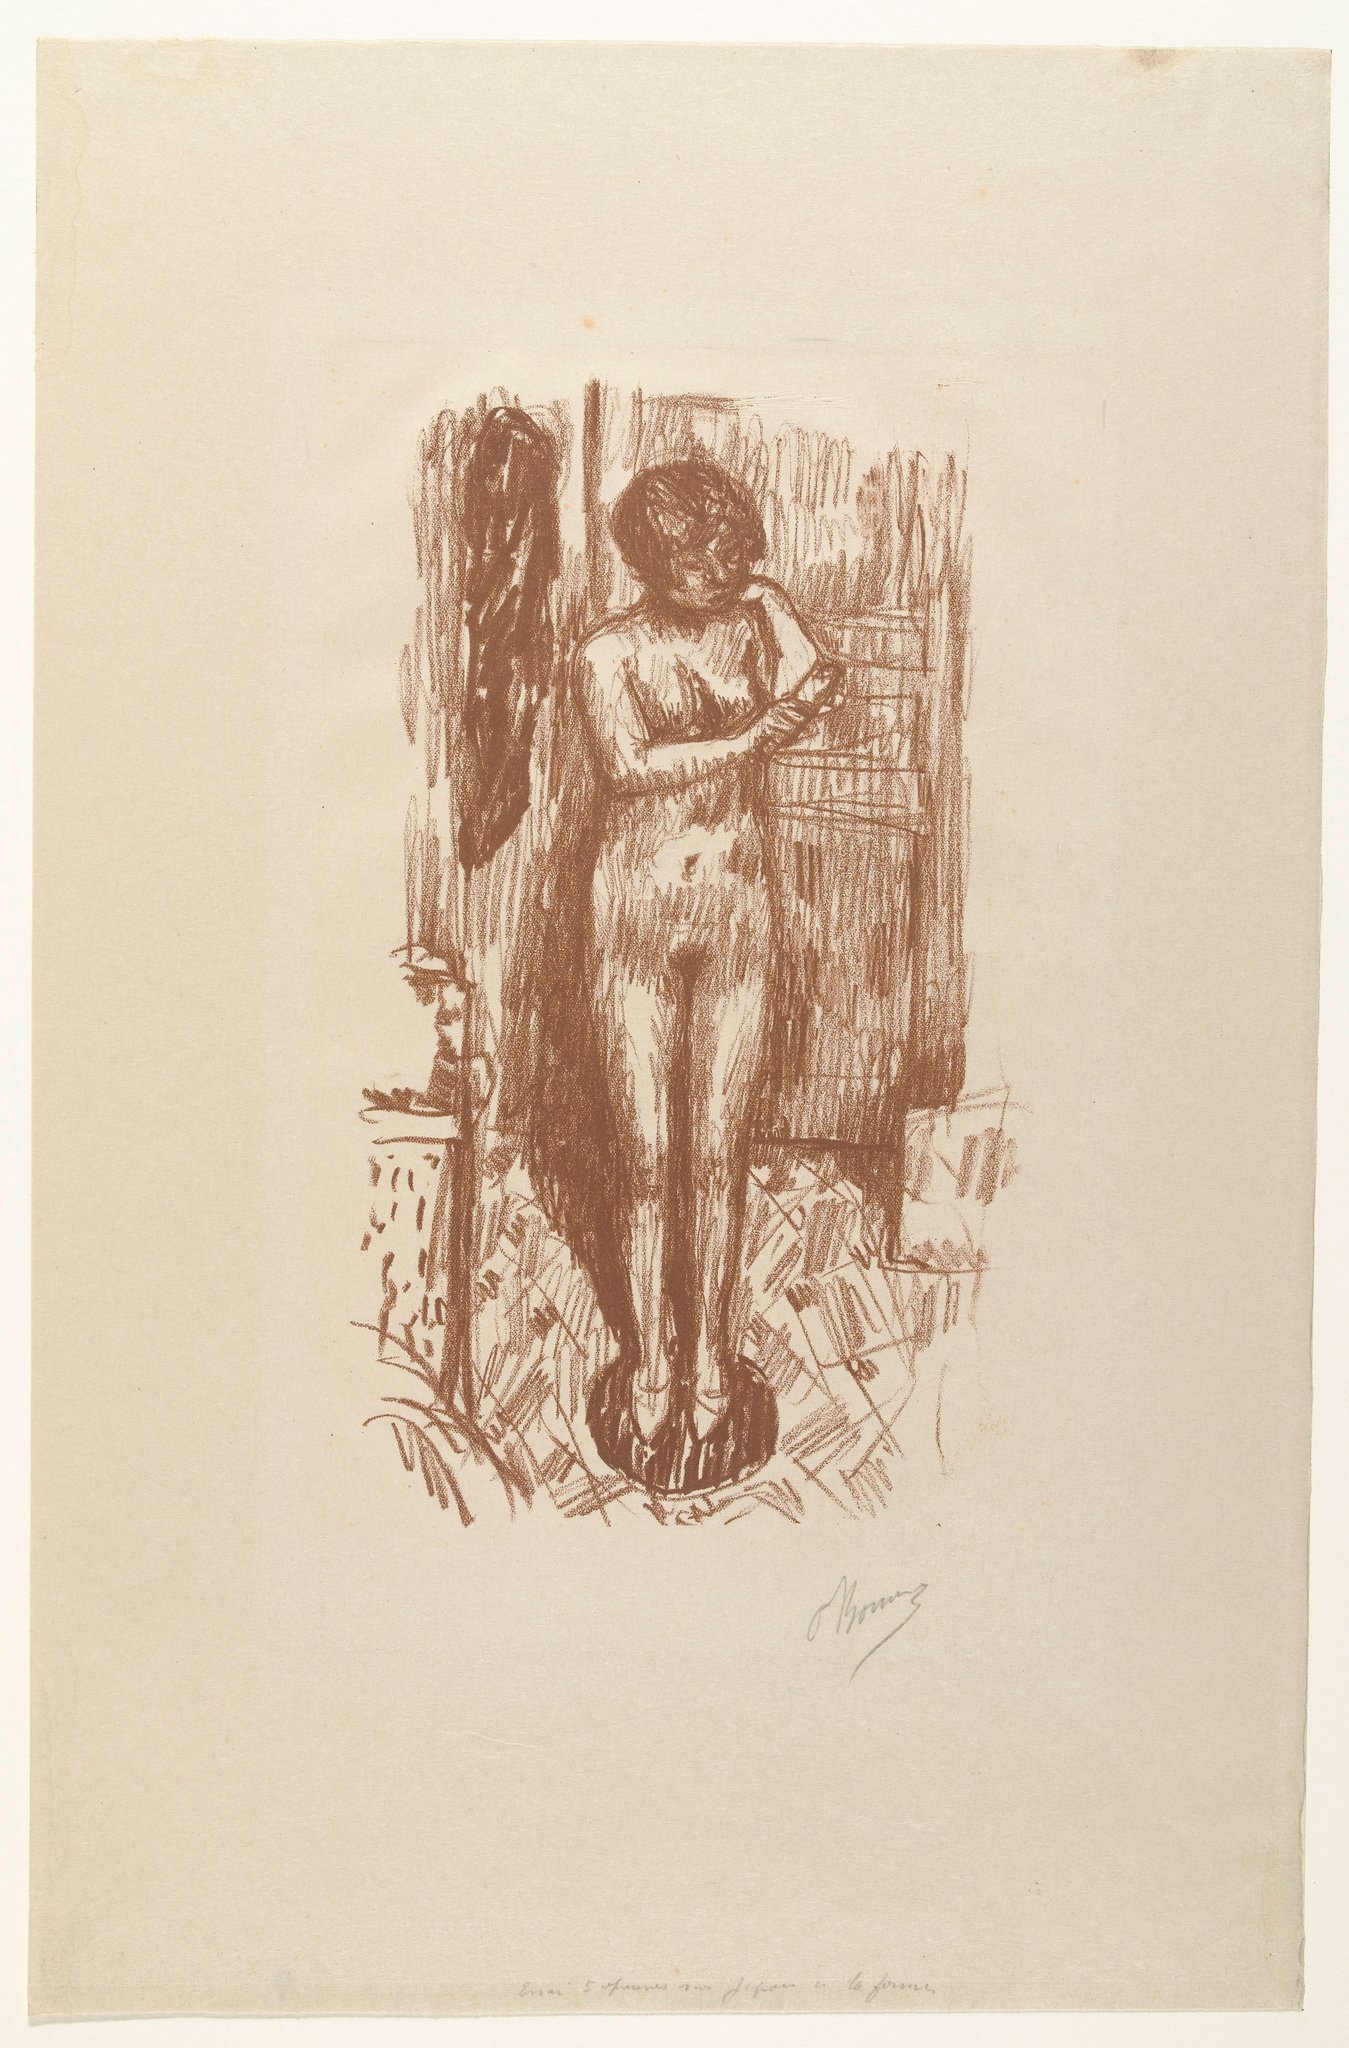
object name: print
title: Etude de Nu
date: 1923-1927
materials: paper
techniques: lithograph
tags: the (nude) human figure; 'corpo humano' (ripa), female sex; woman, washing and bathing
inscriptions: collector's mark: Lugt 2929a, collector's mark: Lugt 2228